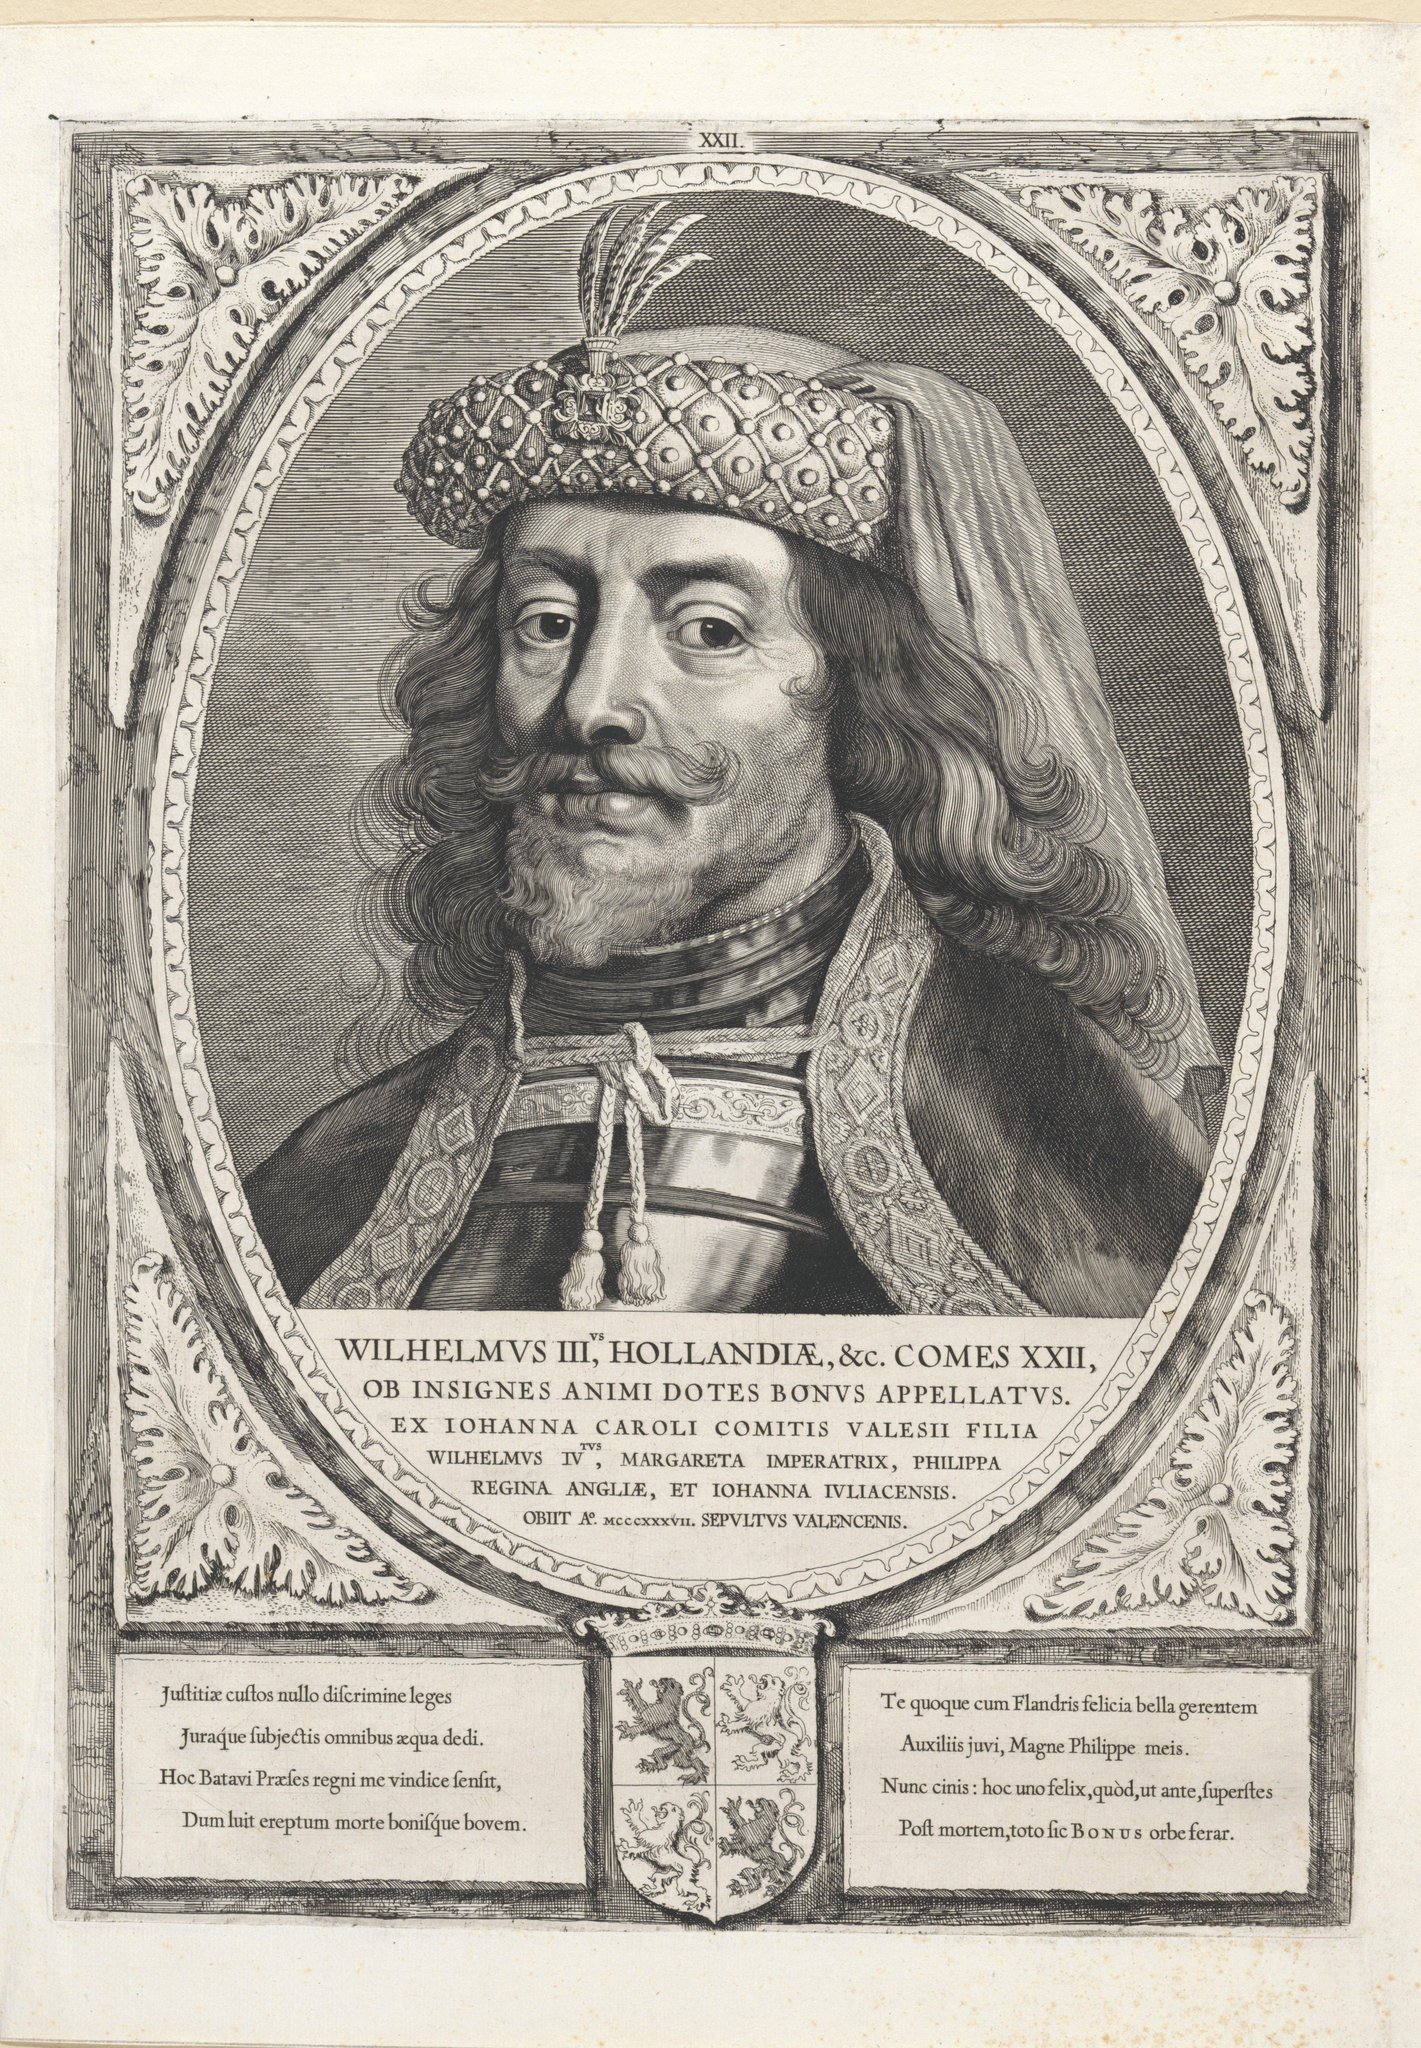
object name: print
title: Portret van Willem III, graaf van Holland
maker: cornelis visscher (ii)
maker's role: draughtsman, painter, print maker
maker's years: 1628-1658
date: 1650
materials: paper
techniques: engraving, etching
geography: haarlem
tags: willem iii de goede (graaf van holland en henegouwen), head-gear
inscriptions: collector's mark: Lugt 12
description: Willem III de Goede, graaf van Holland en Henegouwen. Hij draagt een met veren en parels verfraaide hoofddeksel. De omlijsting is versierd met het wapen van Holland.